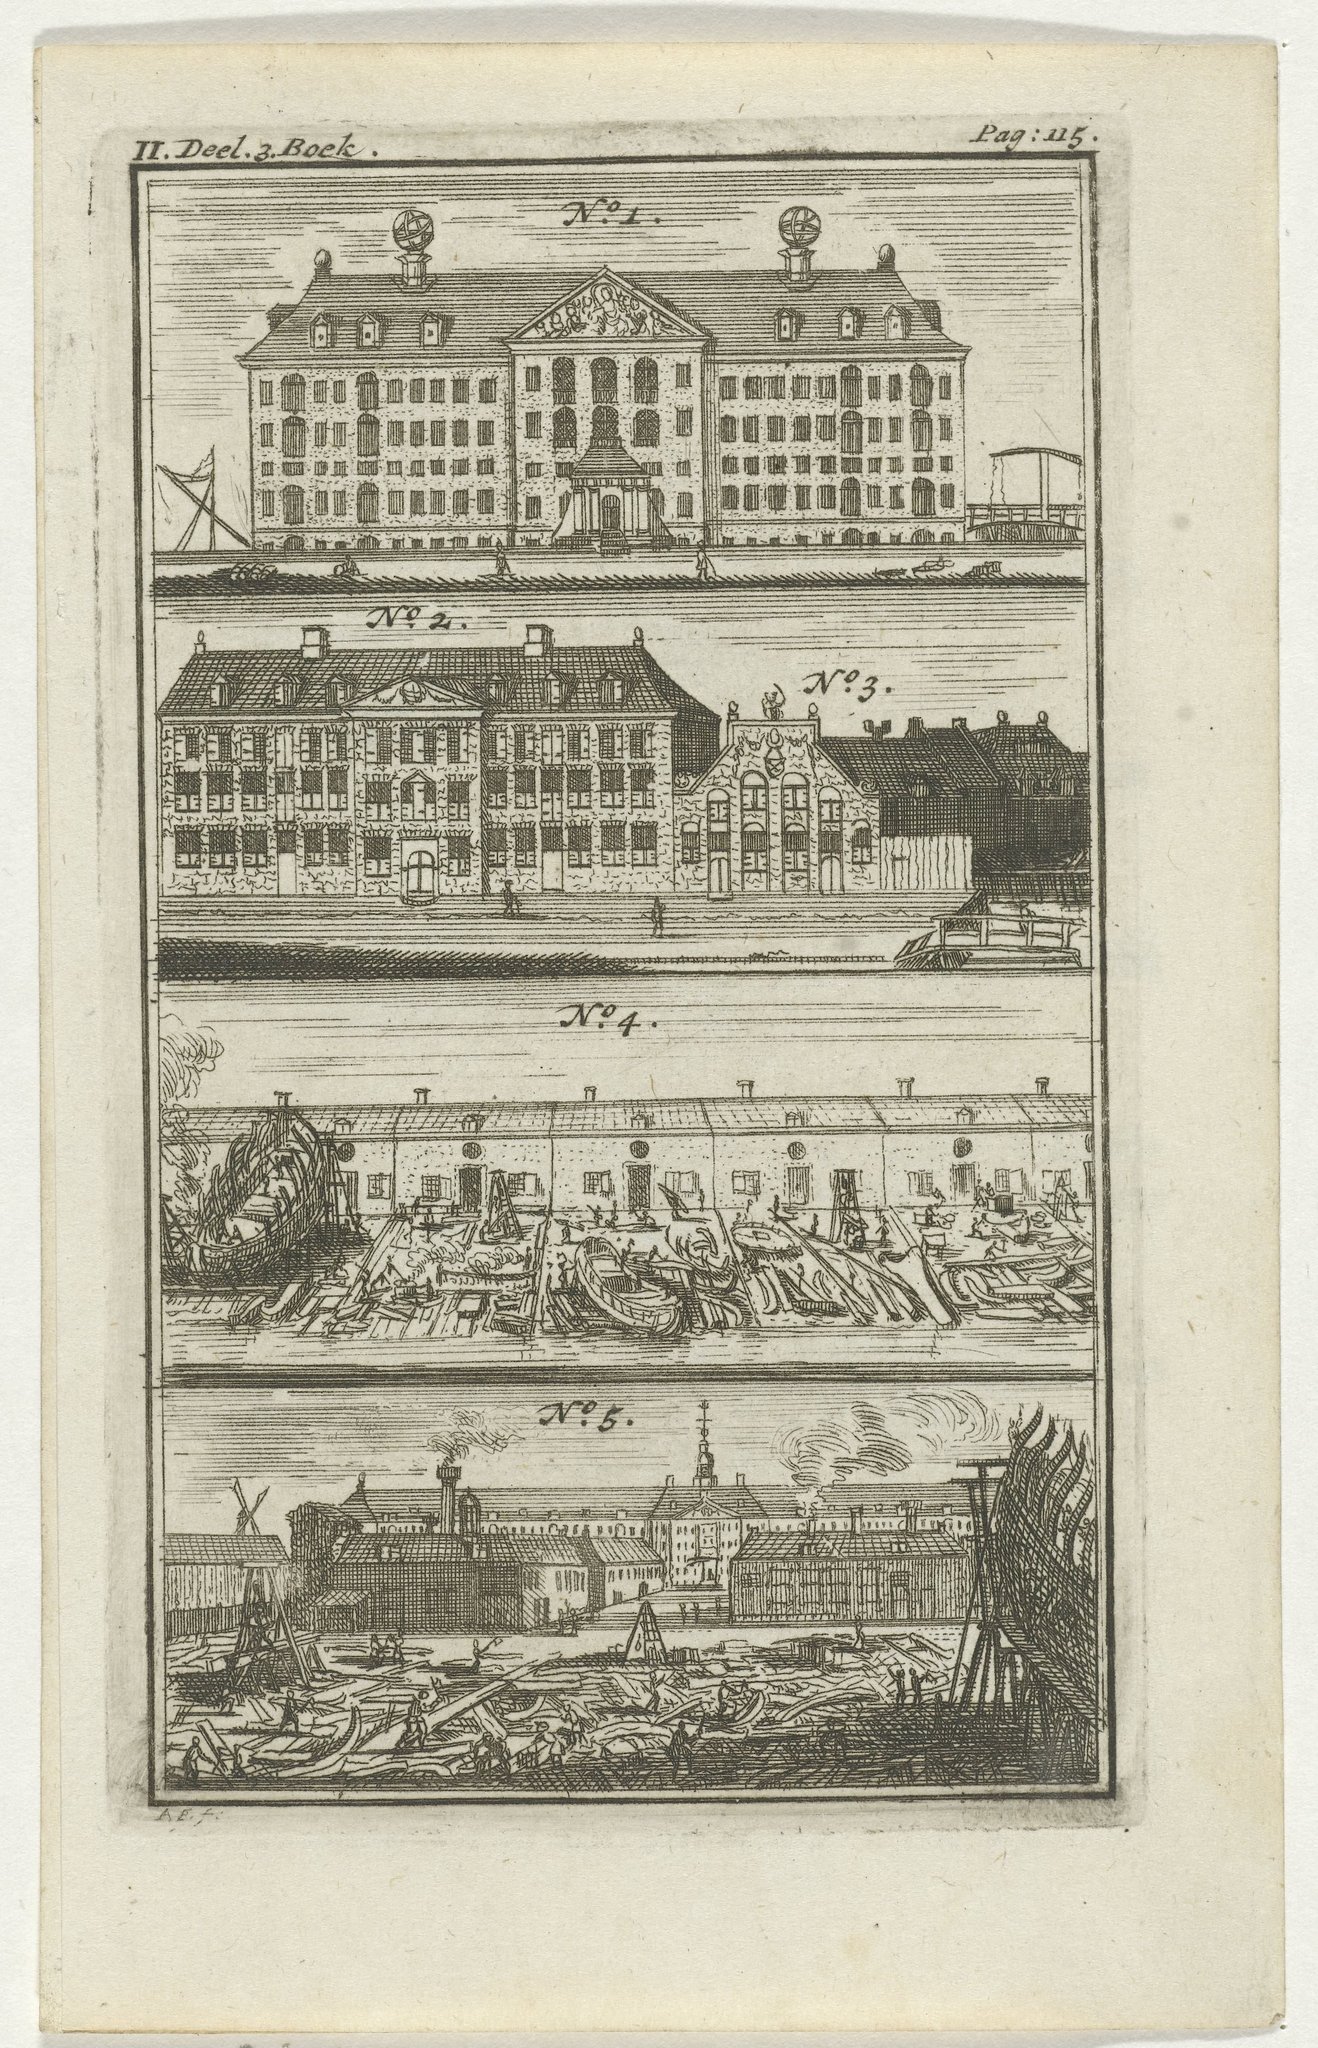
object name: text sheet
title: Tekstblad bij boekillustratie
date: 1723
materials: paper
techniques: letterpress printing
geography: amsterdam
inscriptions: collector's mark: Lugt 2760, collector's mark: Lugt 2228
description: Tekstblad uit: Leuve, Roeland van. 's Waerelds koopslot of De Amsteldamse beurs. Amsterdam: Jacobus Verheyden (I), 1723.